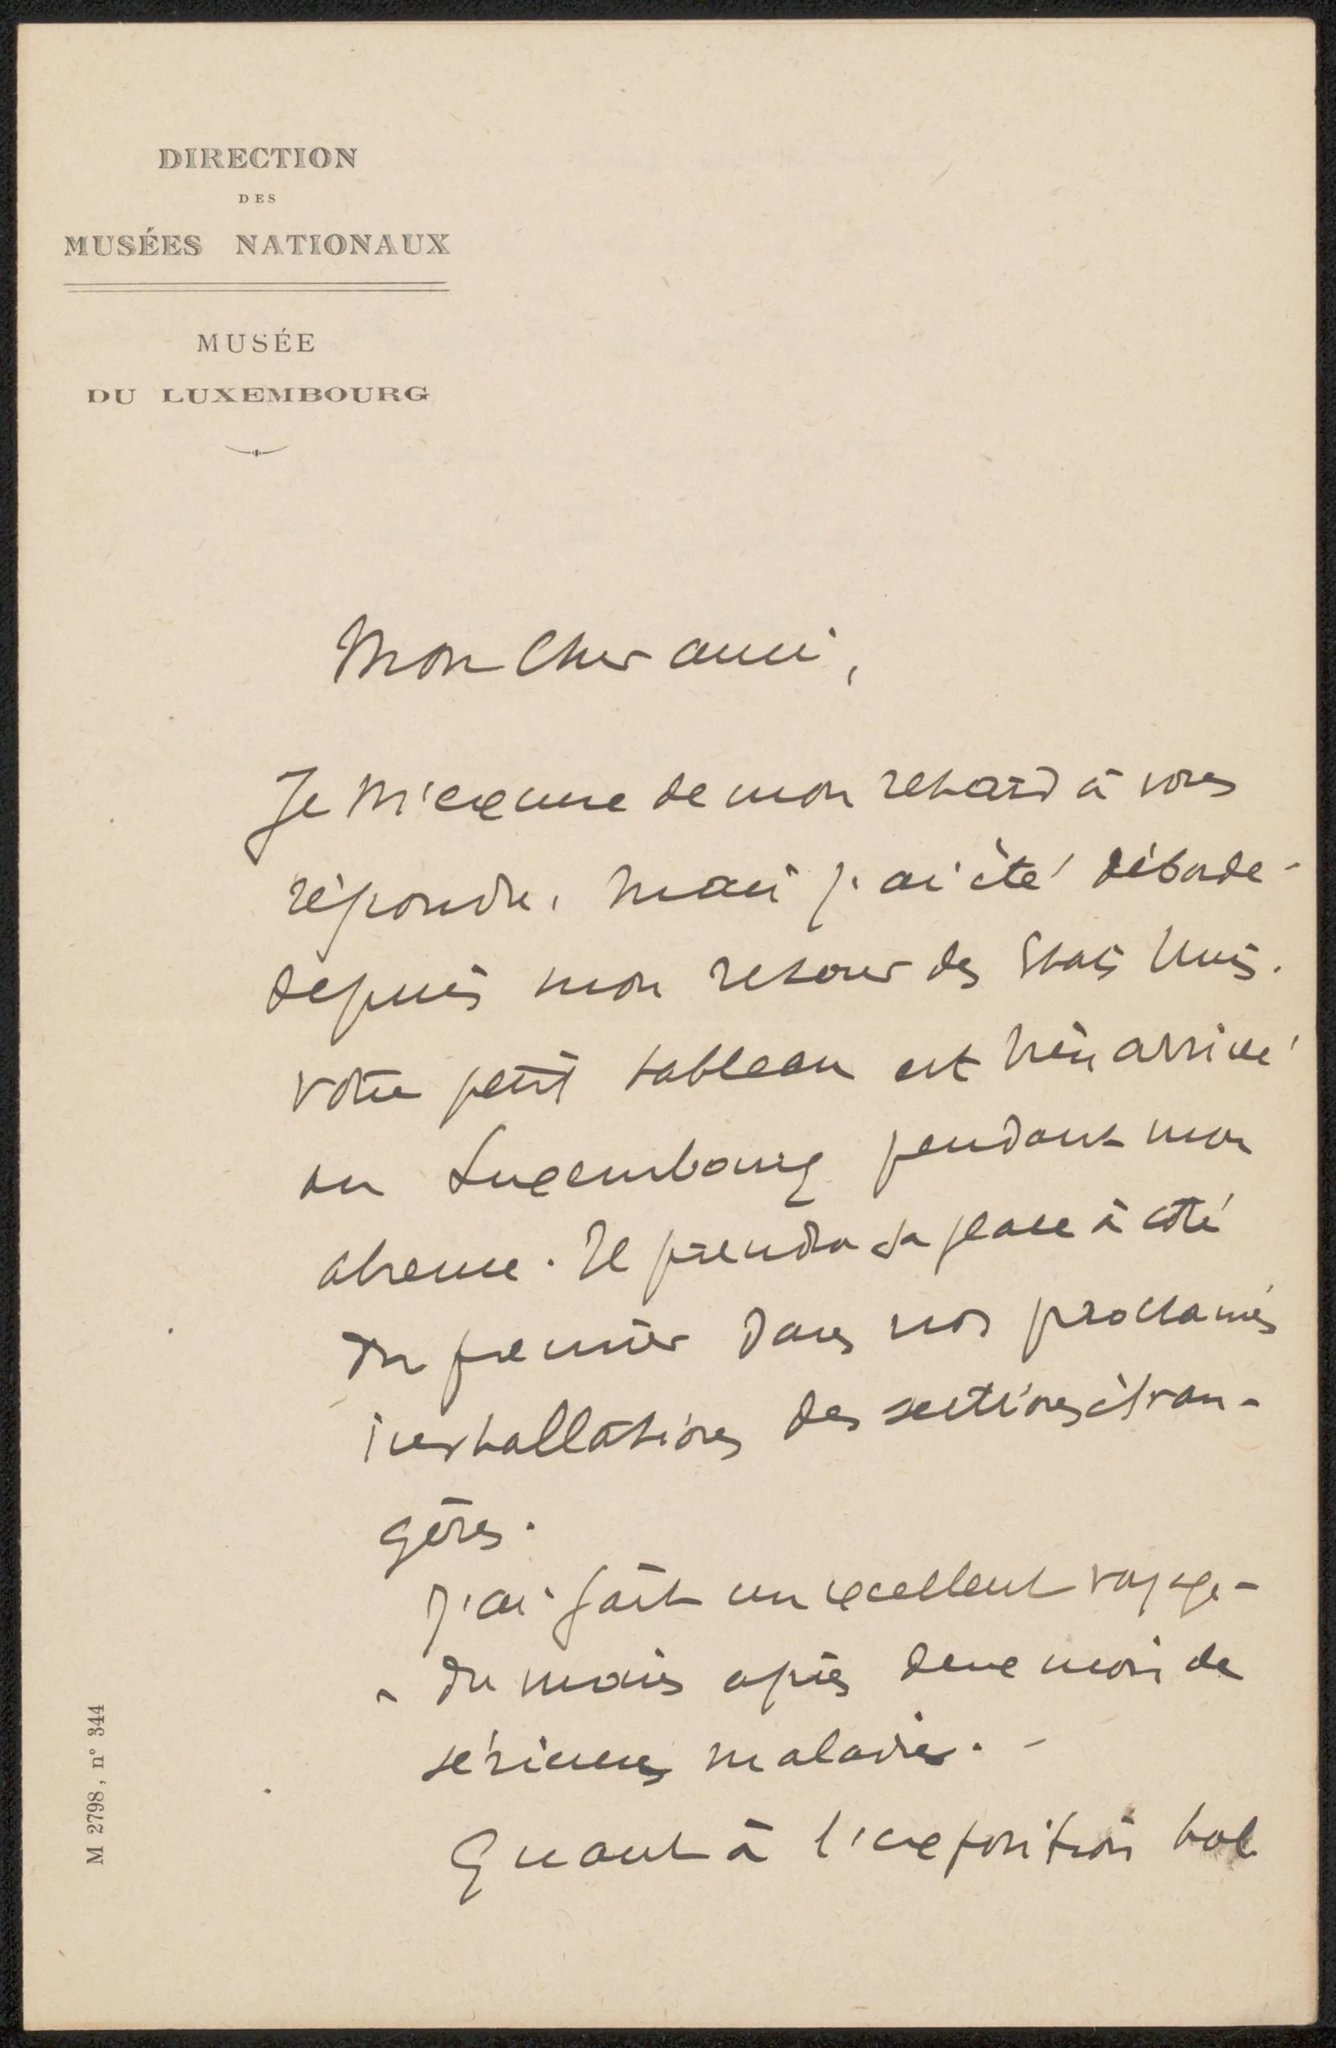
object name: letter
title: Brief aan Philip Zilcken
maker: léonce bénédite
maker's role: conservator, museumdirecteur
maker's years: 1856-1925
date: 1920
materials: ink, paper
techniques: pen, printing, writing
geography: paris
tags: the hague, painter, draughtsman, philip zilcken, travelling; tourism, painting (including book-illumination, miniature-painting)